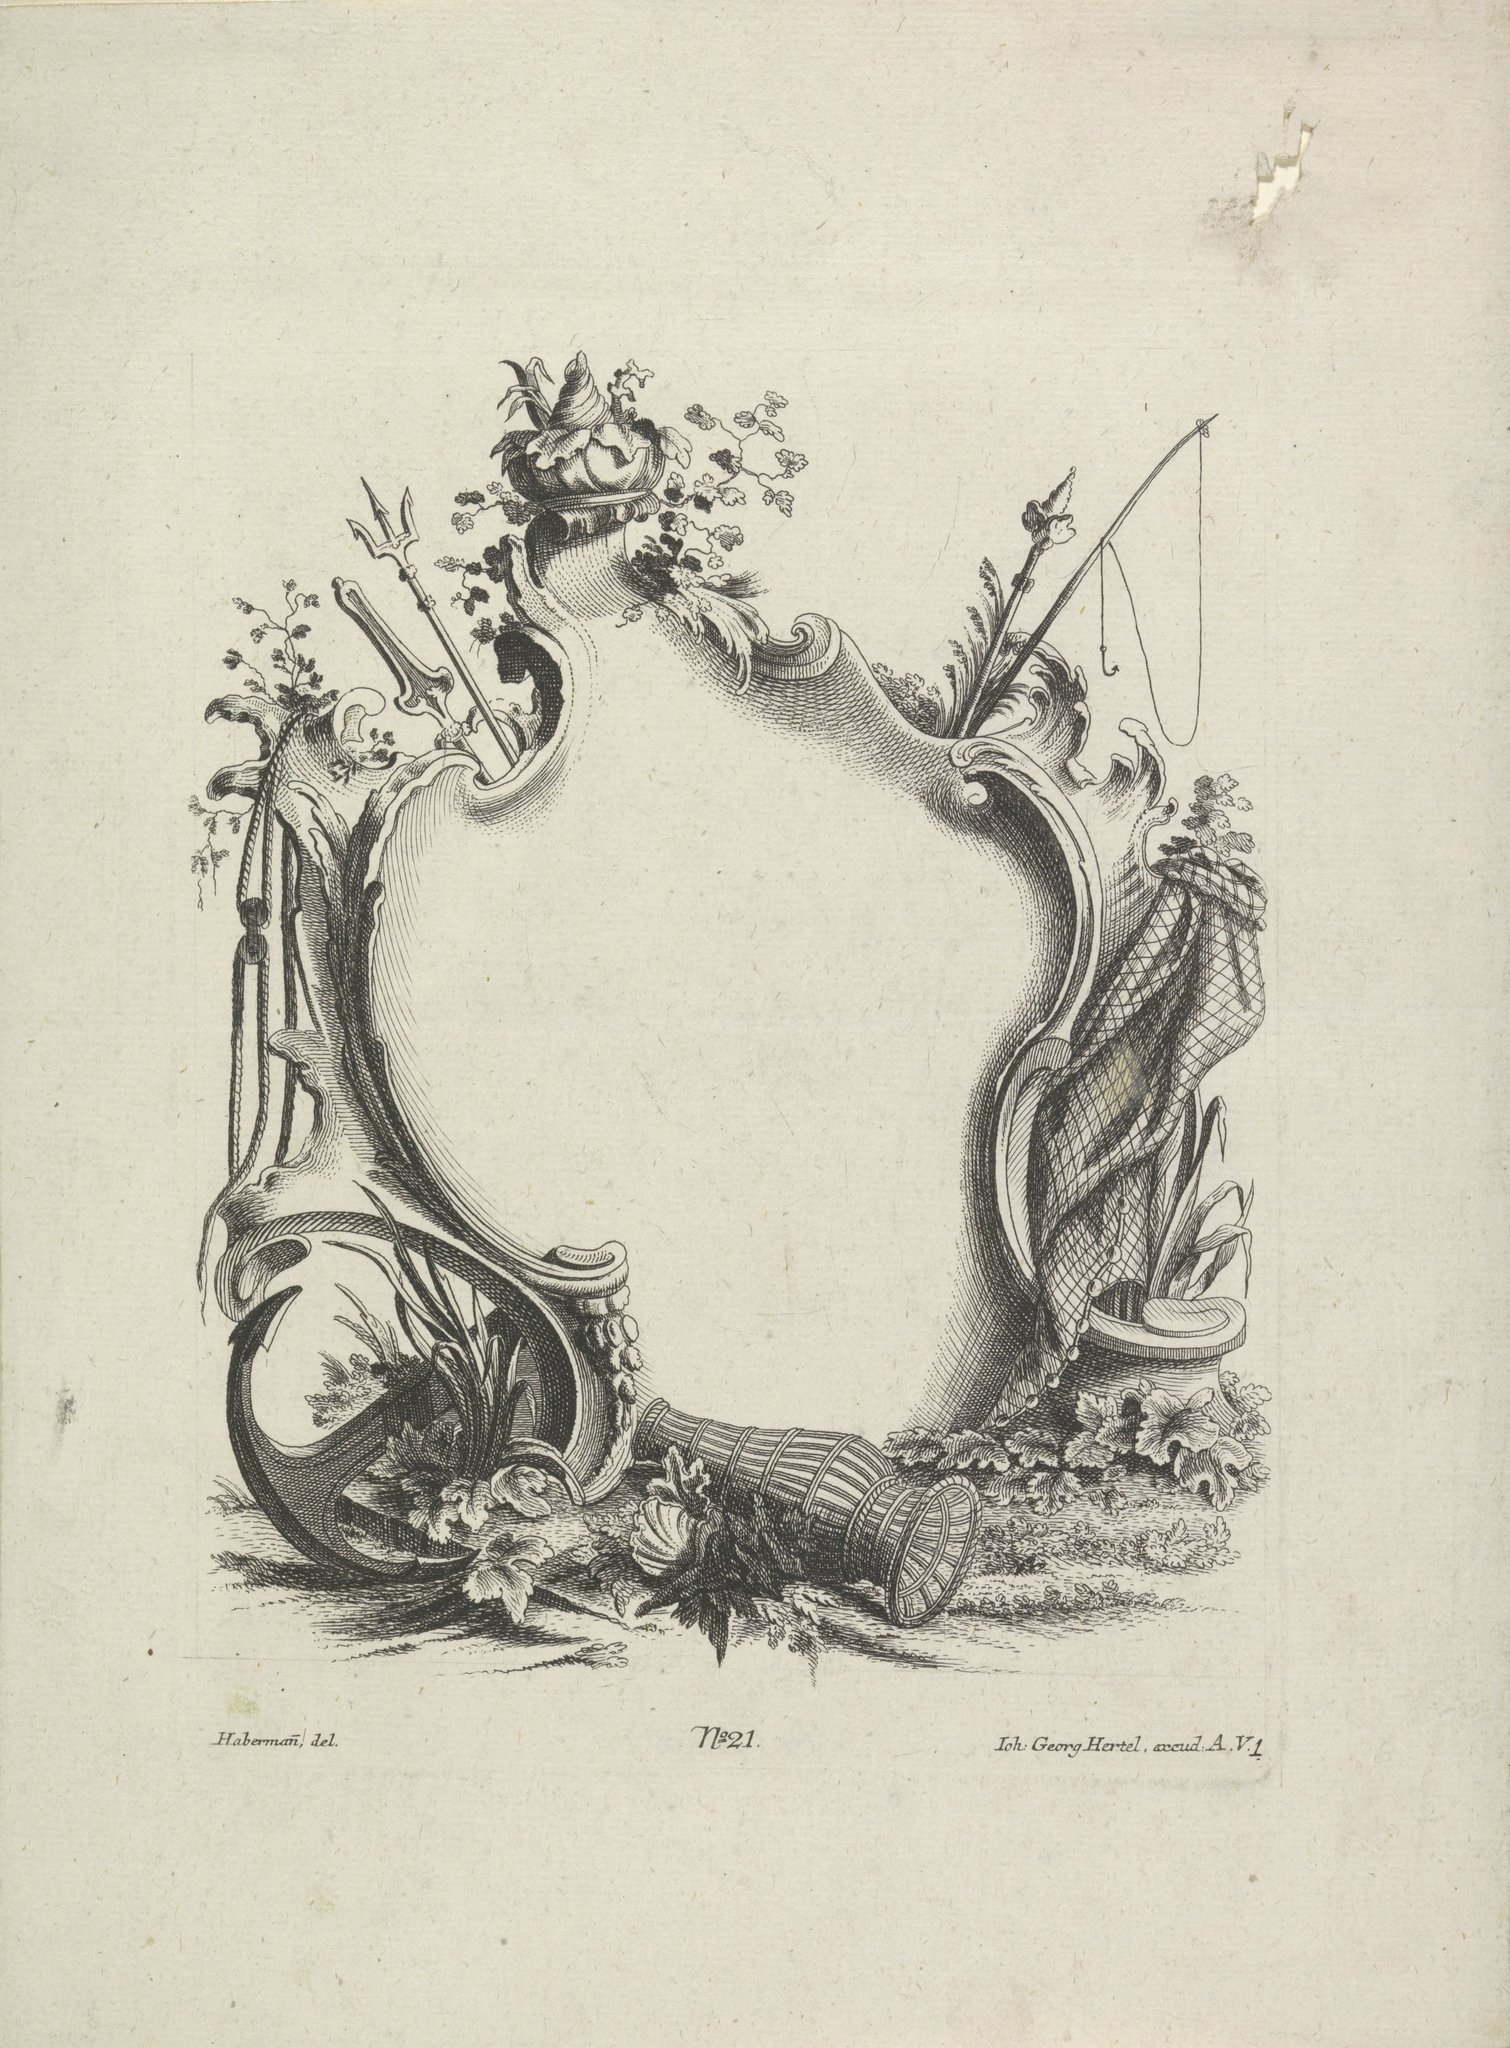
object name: print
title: Cartouches met emblemen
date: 1731-1775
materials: paper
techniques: etching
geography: augsburg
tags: sea (seascape), ornament ~ cartouche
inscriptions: collector's mark: Lugt 2760, collector's mark: Lugt 2228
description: Rocaille cartouche met maritieme objecten zoals een anker, drietand, schelp, hengel en een visnet. Uitgeversnummer 21.